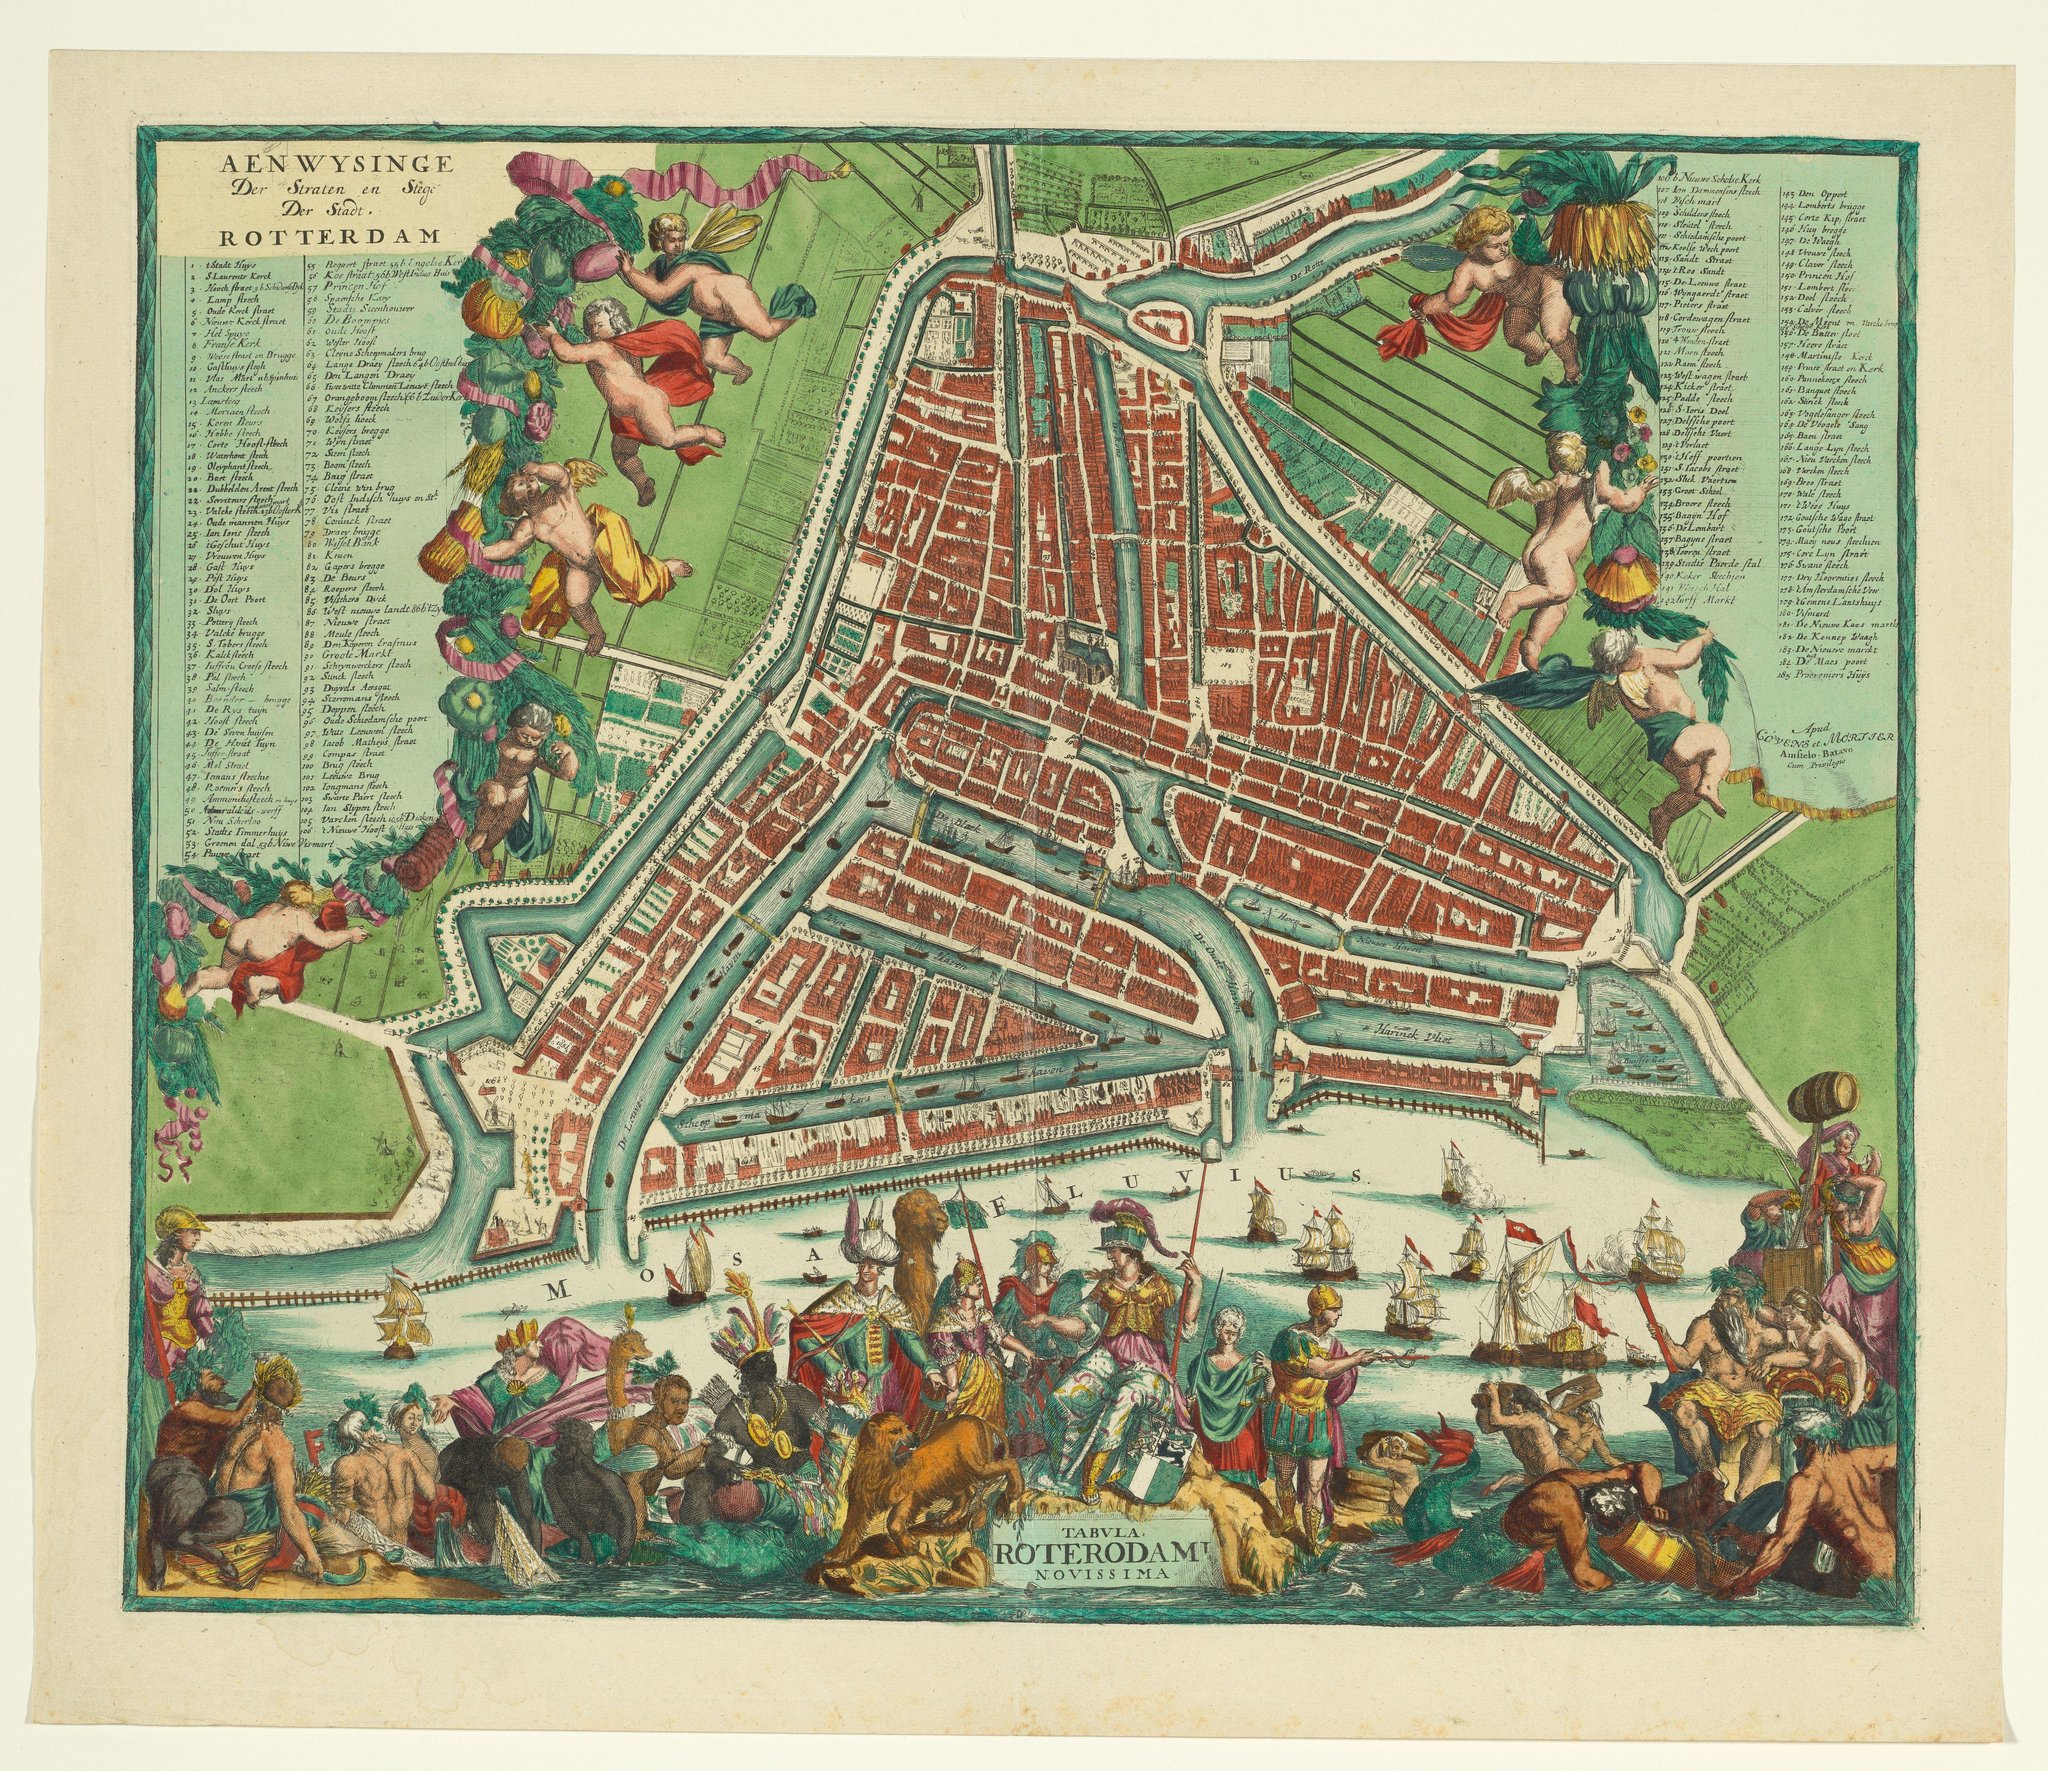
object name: print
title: Plattegrond van Rotterdam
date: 1721-1774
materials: paper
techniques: engraving, etching, hand coloring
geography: amsterdam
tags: coat of arms (as symbol of the state, etc.) (+ city; municipal), triton(s), river-gods, maps of cities, rotterdam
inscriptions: collector's mark: Lugt 2228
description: Eerdere staten van plattegrond mogelijk bedoeld als onderdeel van groter geheel, zie documentatie (Ratsma, 1997) voor meer informatie. Eerdere (derde) staat van prent ook gebruikt in: Theatrum ichnographicum omnium urbium et praecipuorum oppidorum Belgicarum XVII Provinciarum (…). Amsterdam: Frederik de Wit, ca. 1700-1710. Voor tweede staat zie RP-P-AO-13-11.